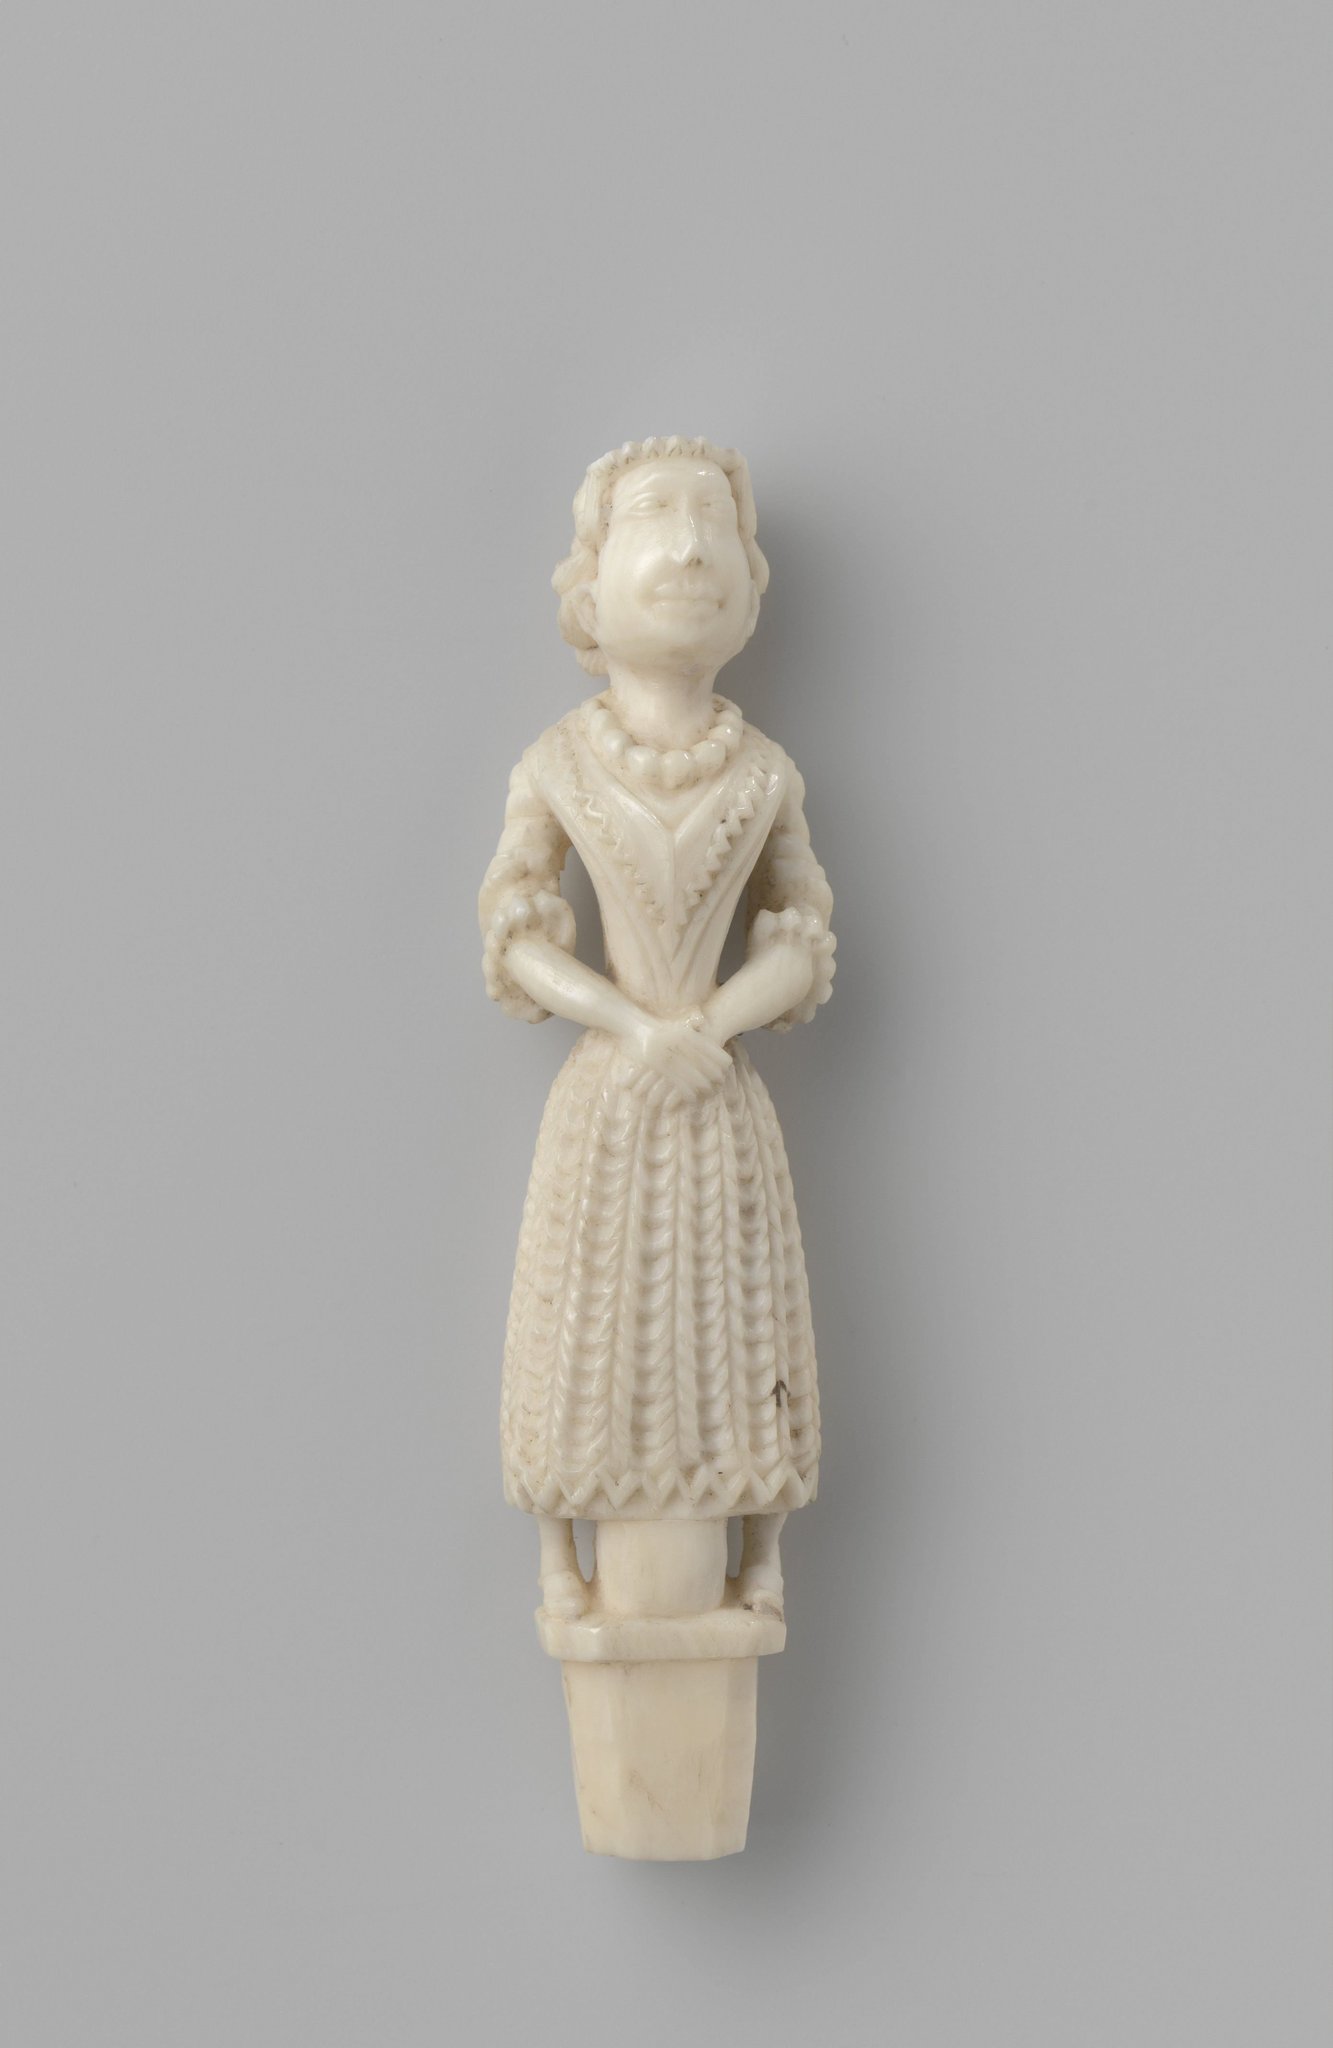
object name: knife handle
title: Fork Handle with Queen Mary II of England (1662-1692)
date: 1689-1702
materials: ivory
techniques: cutting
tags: the hague, william iii (prince of orange and king of england, scotland, and ireland), london, maria ii stuart (koningin van engeland, schotland en ierland)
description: Orange souvenirs. William III's popularity, and later also that of his wife Mary, gave rise to a wide variety of objects sporting their pictures: medallions, glasses, tiles, cutlery and Delftware pottery.